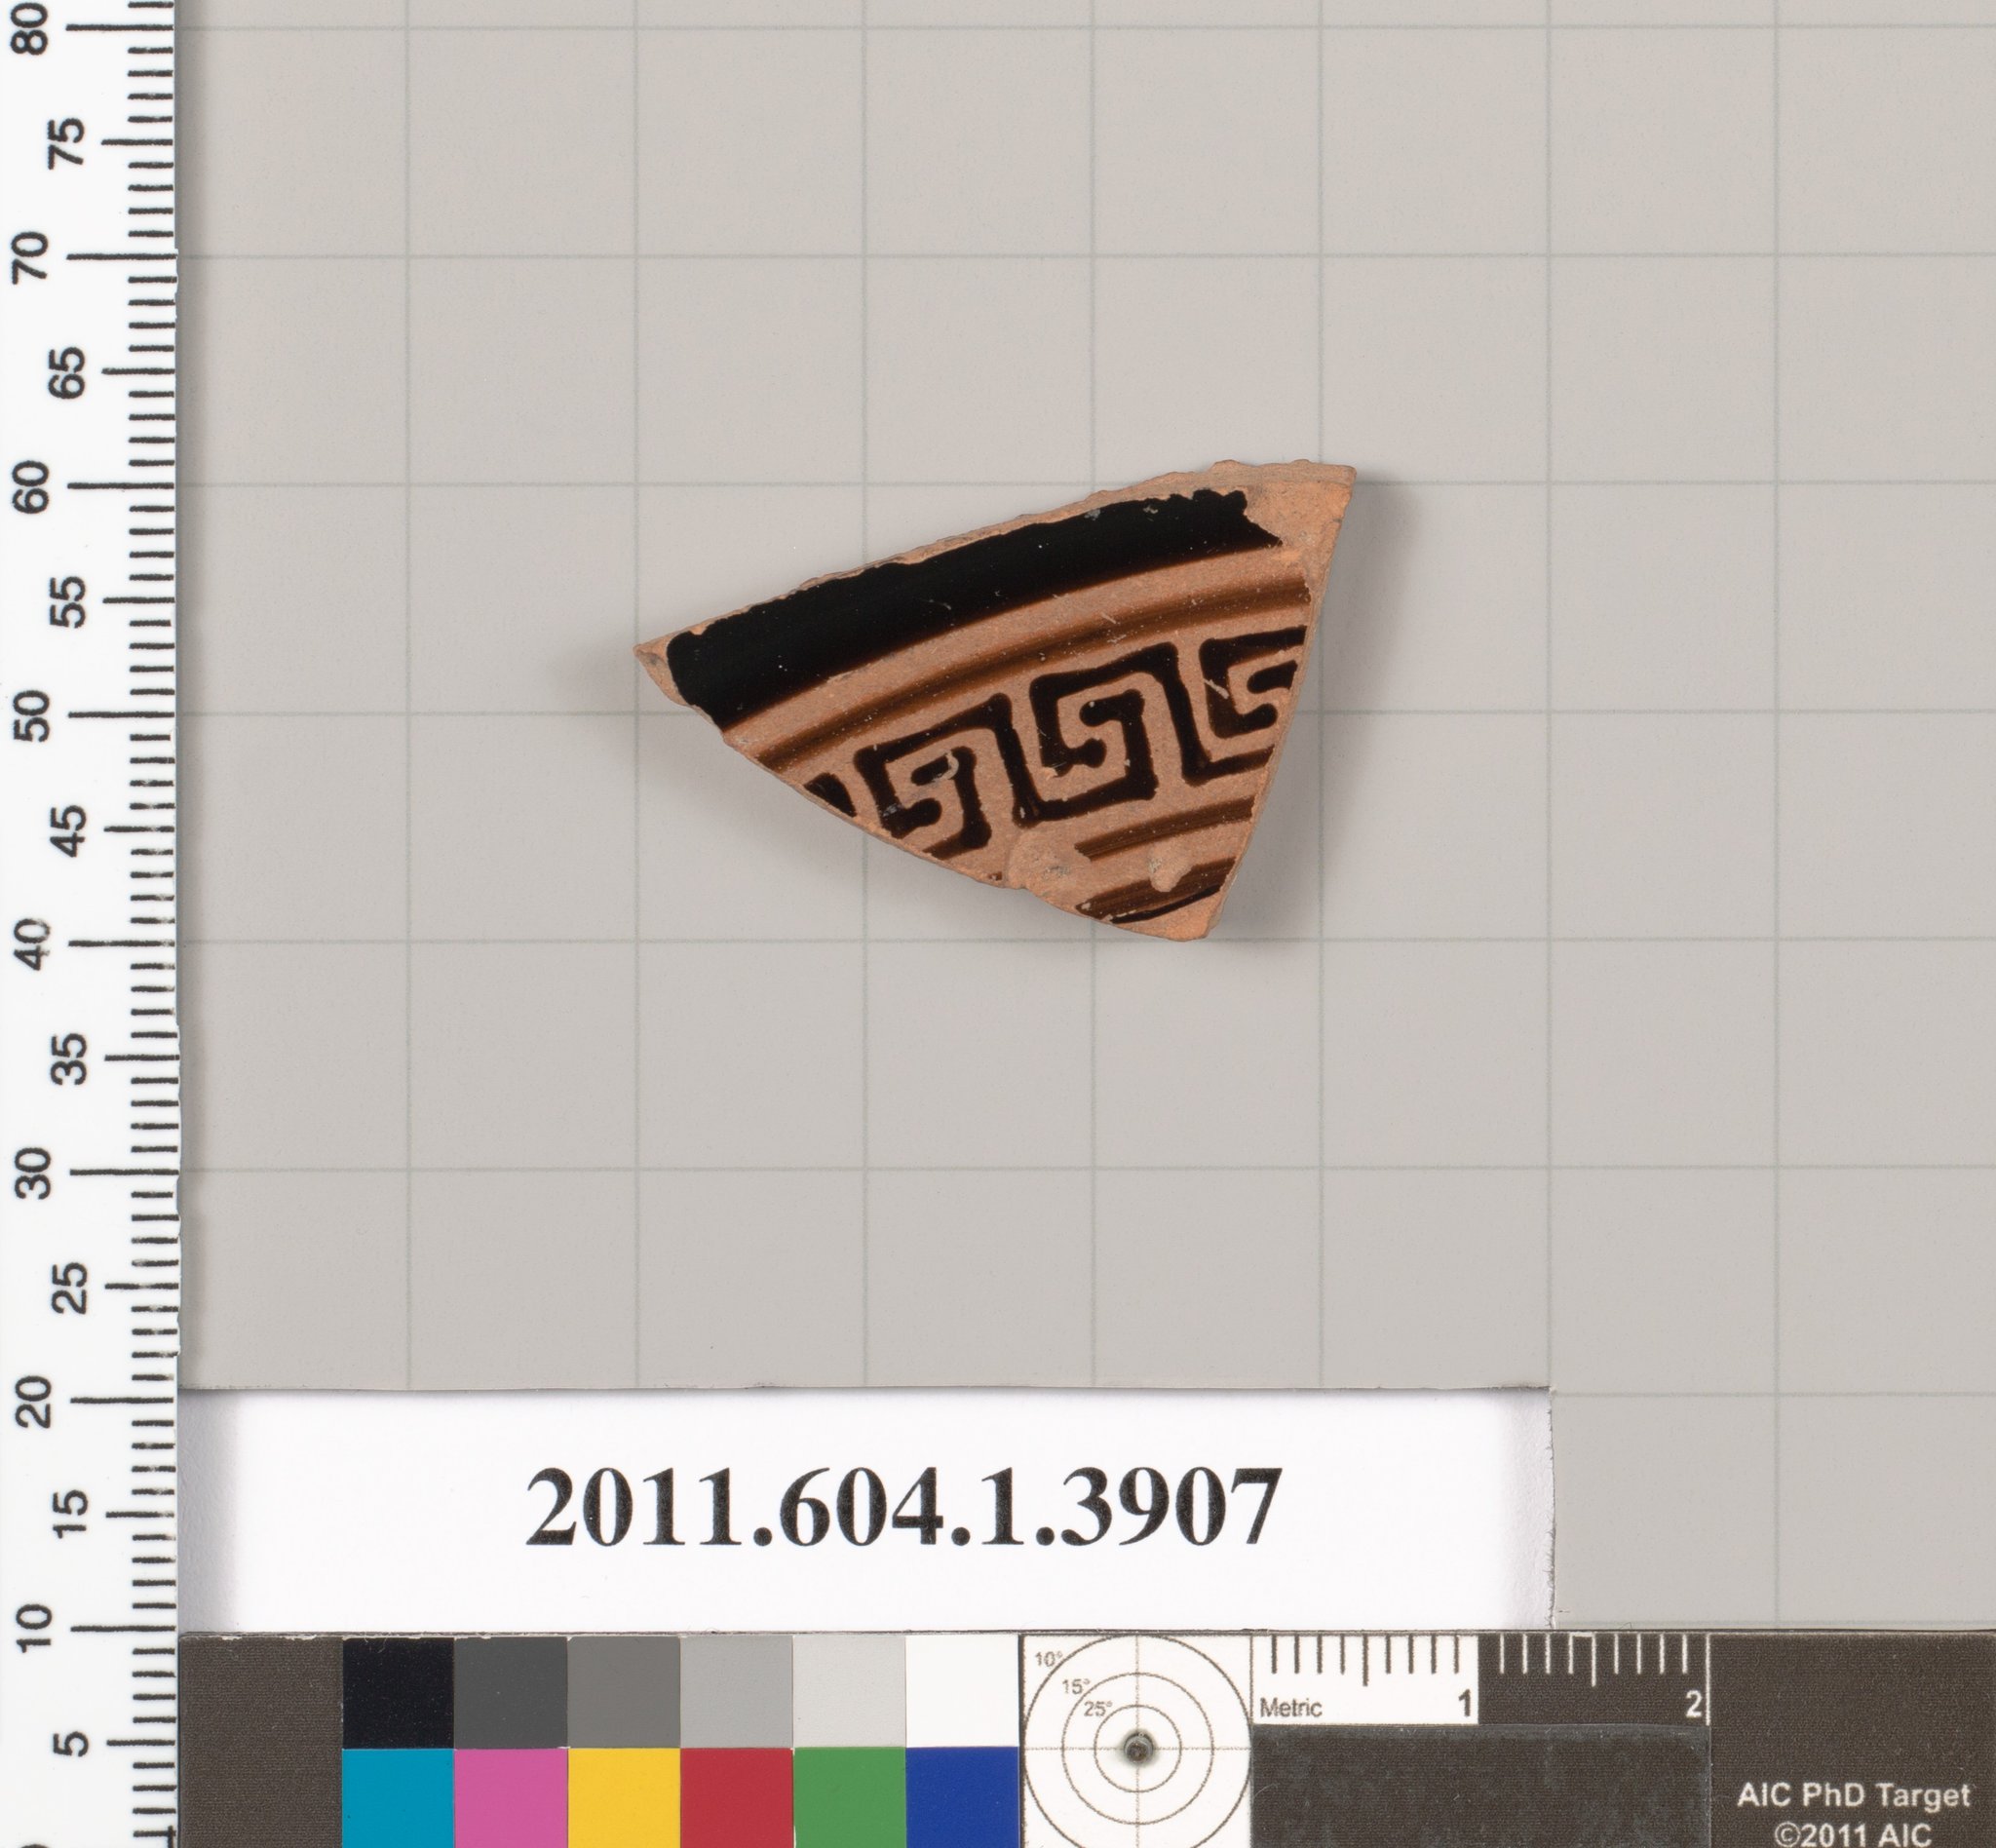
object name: kylix fragment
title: Terracotta fragment of a kylix (drinking cup)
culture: greek, attic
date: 500-476 BCE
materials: terracotta